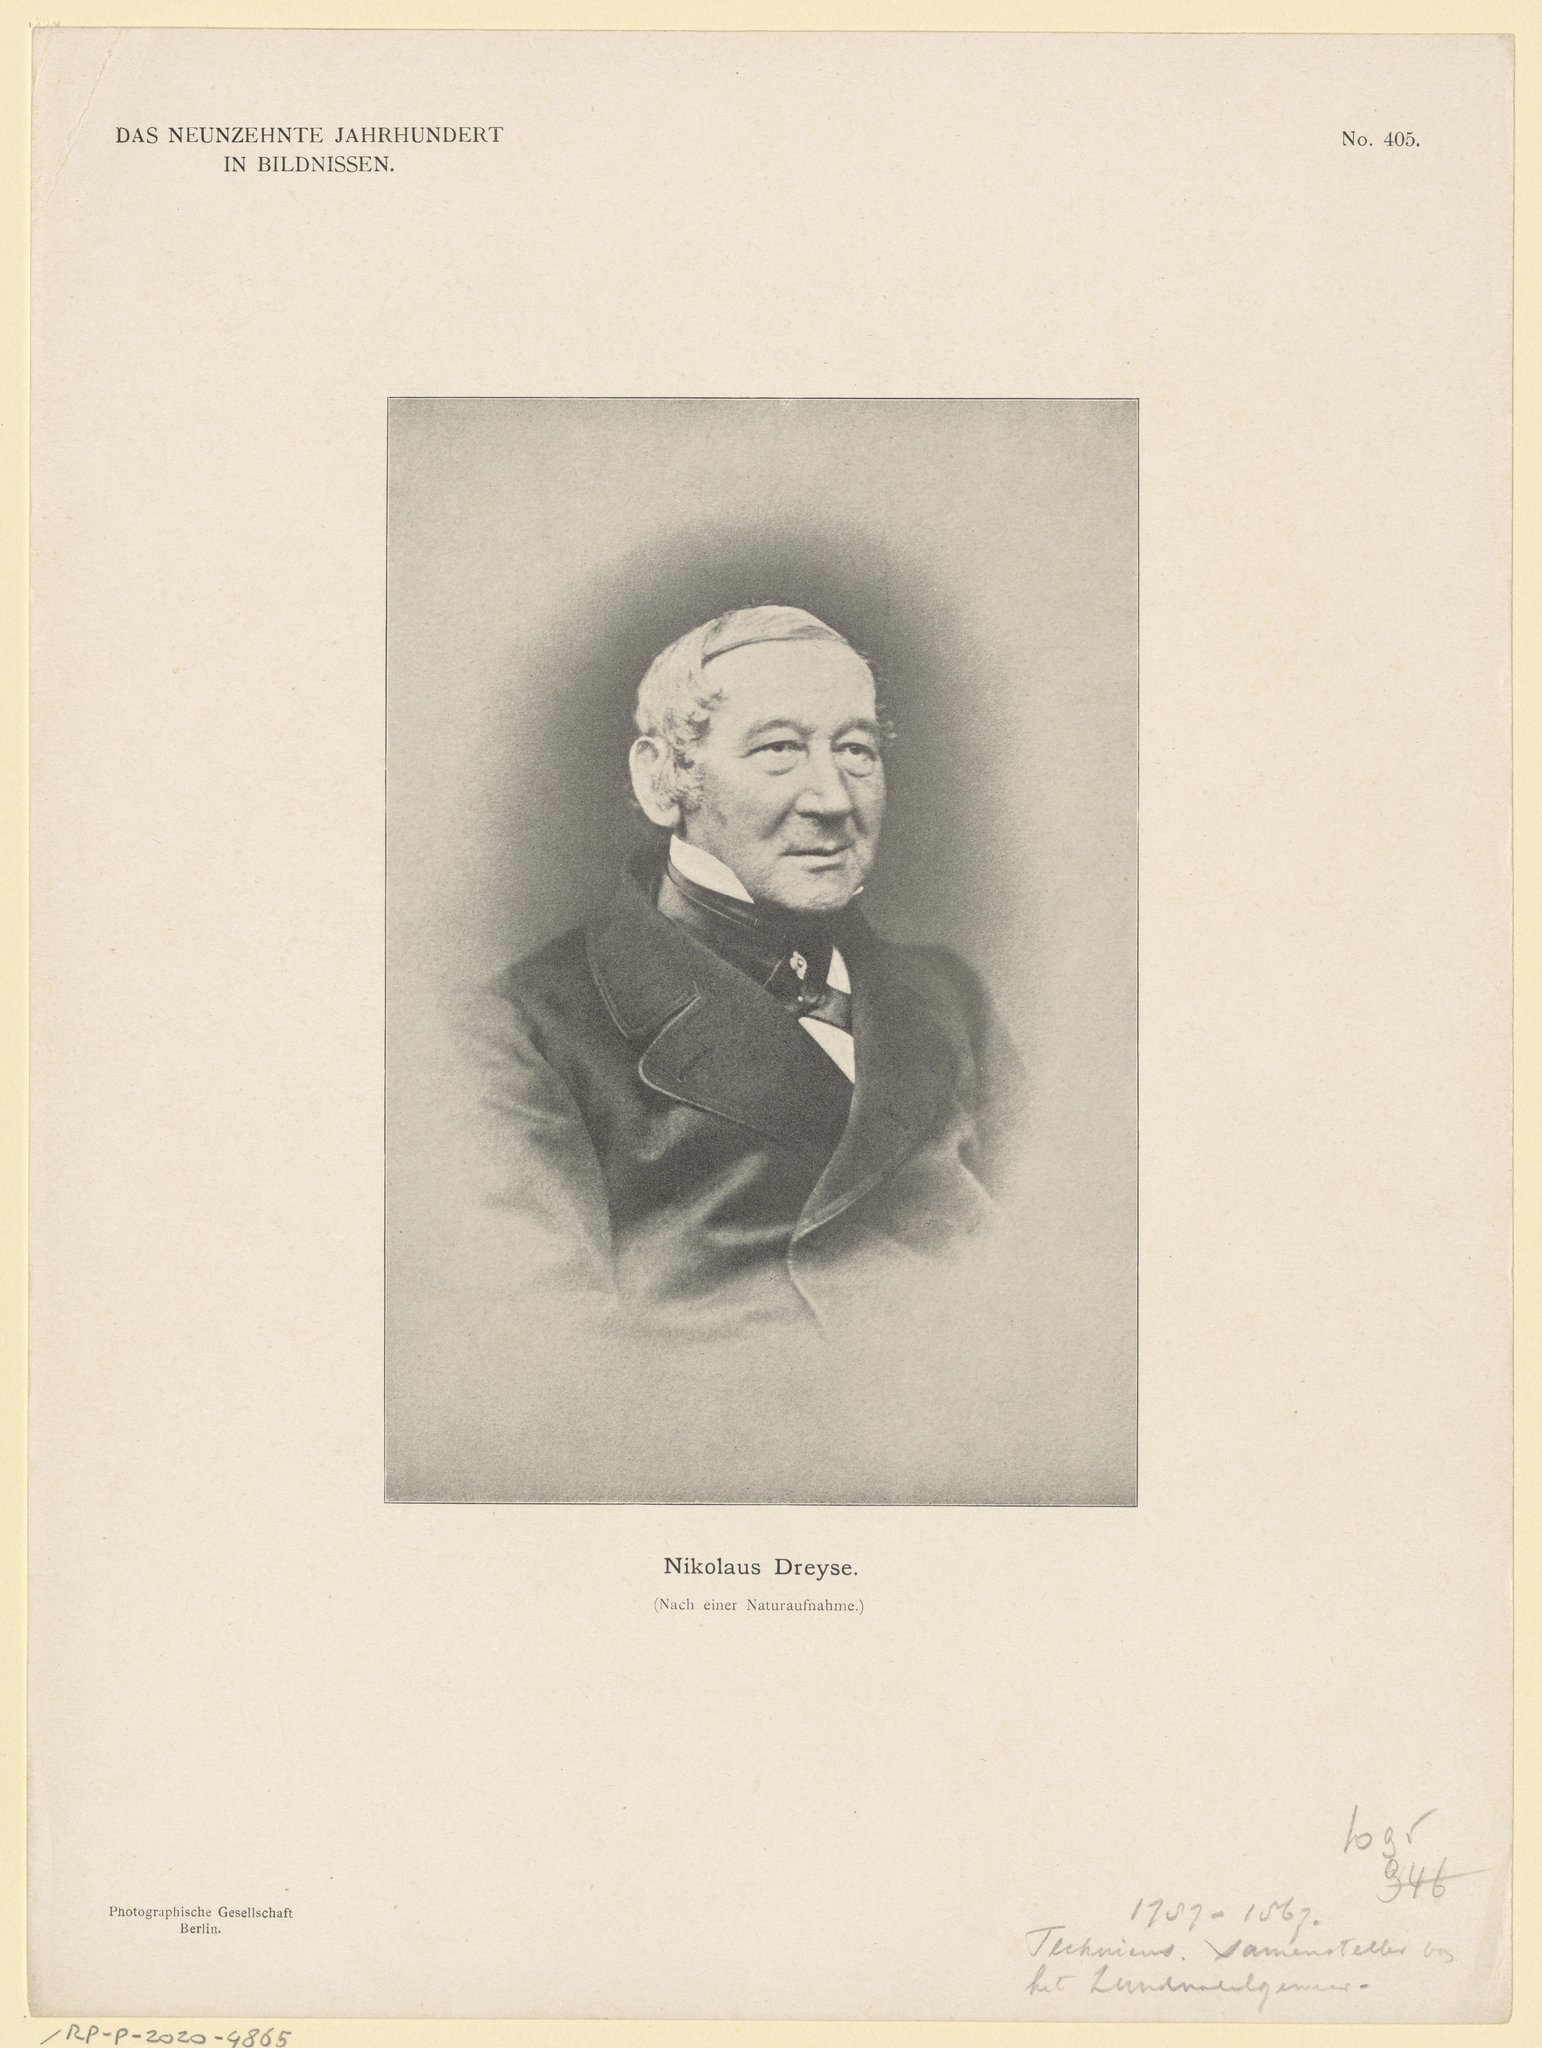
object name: photomechanical print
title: Portret van Johann Nicolaus von Dreyse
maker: Anonymous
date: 1899-1901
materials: paper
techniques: letterpress printing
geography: berlin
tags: historical persons, crafts and industries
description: Fotomechanische afdruk waarschijnlijk uit: Werkmeister, Karl. Das Neunzehnte jahrhundert in Bildnissen. 4 dln. Berlijn: Photographischen Gesellschaft, [1899-1901].